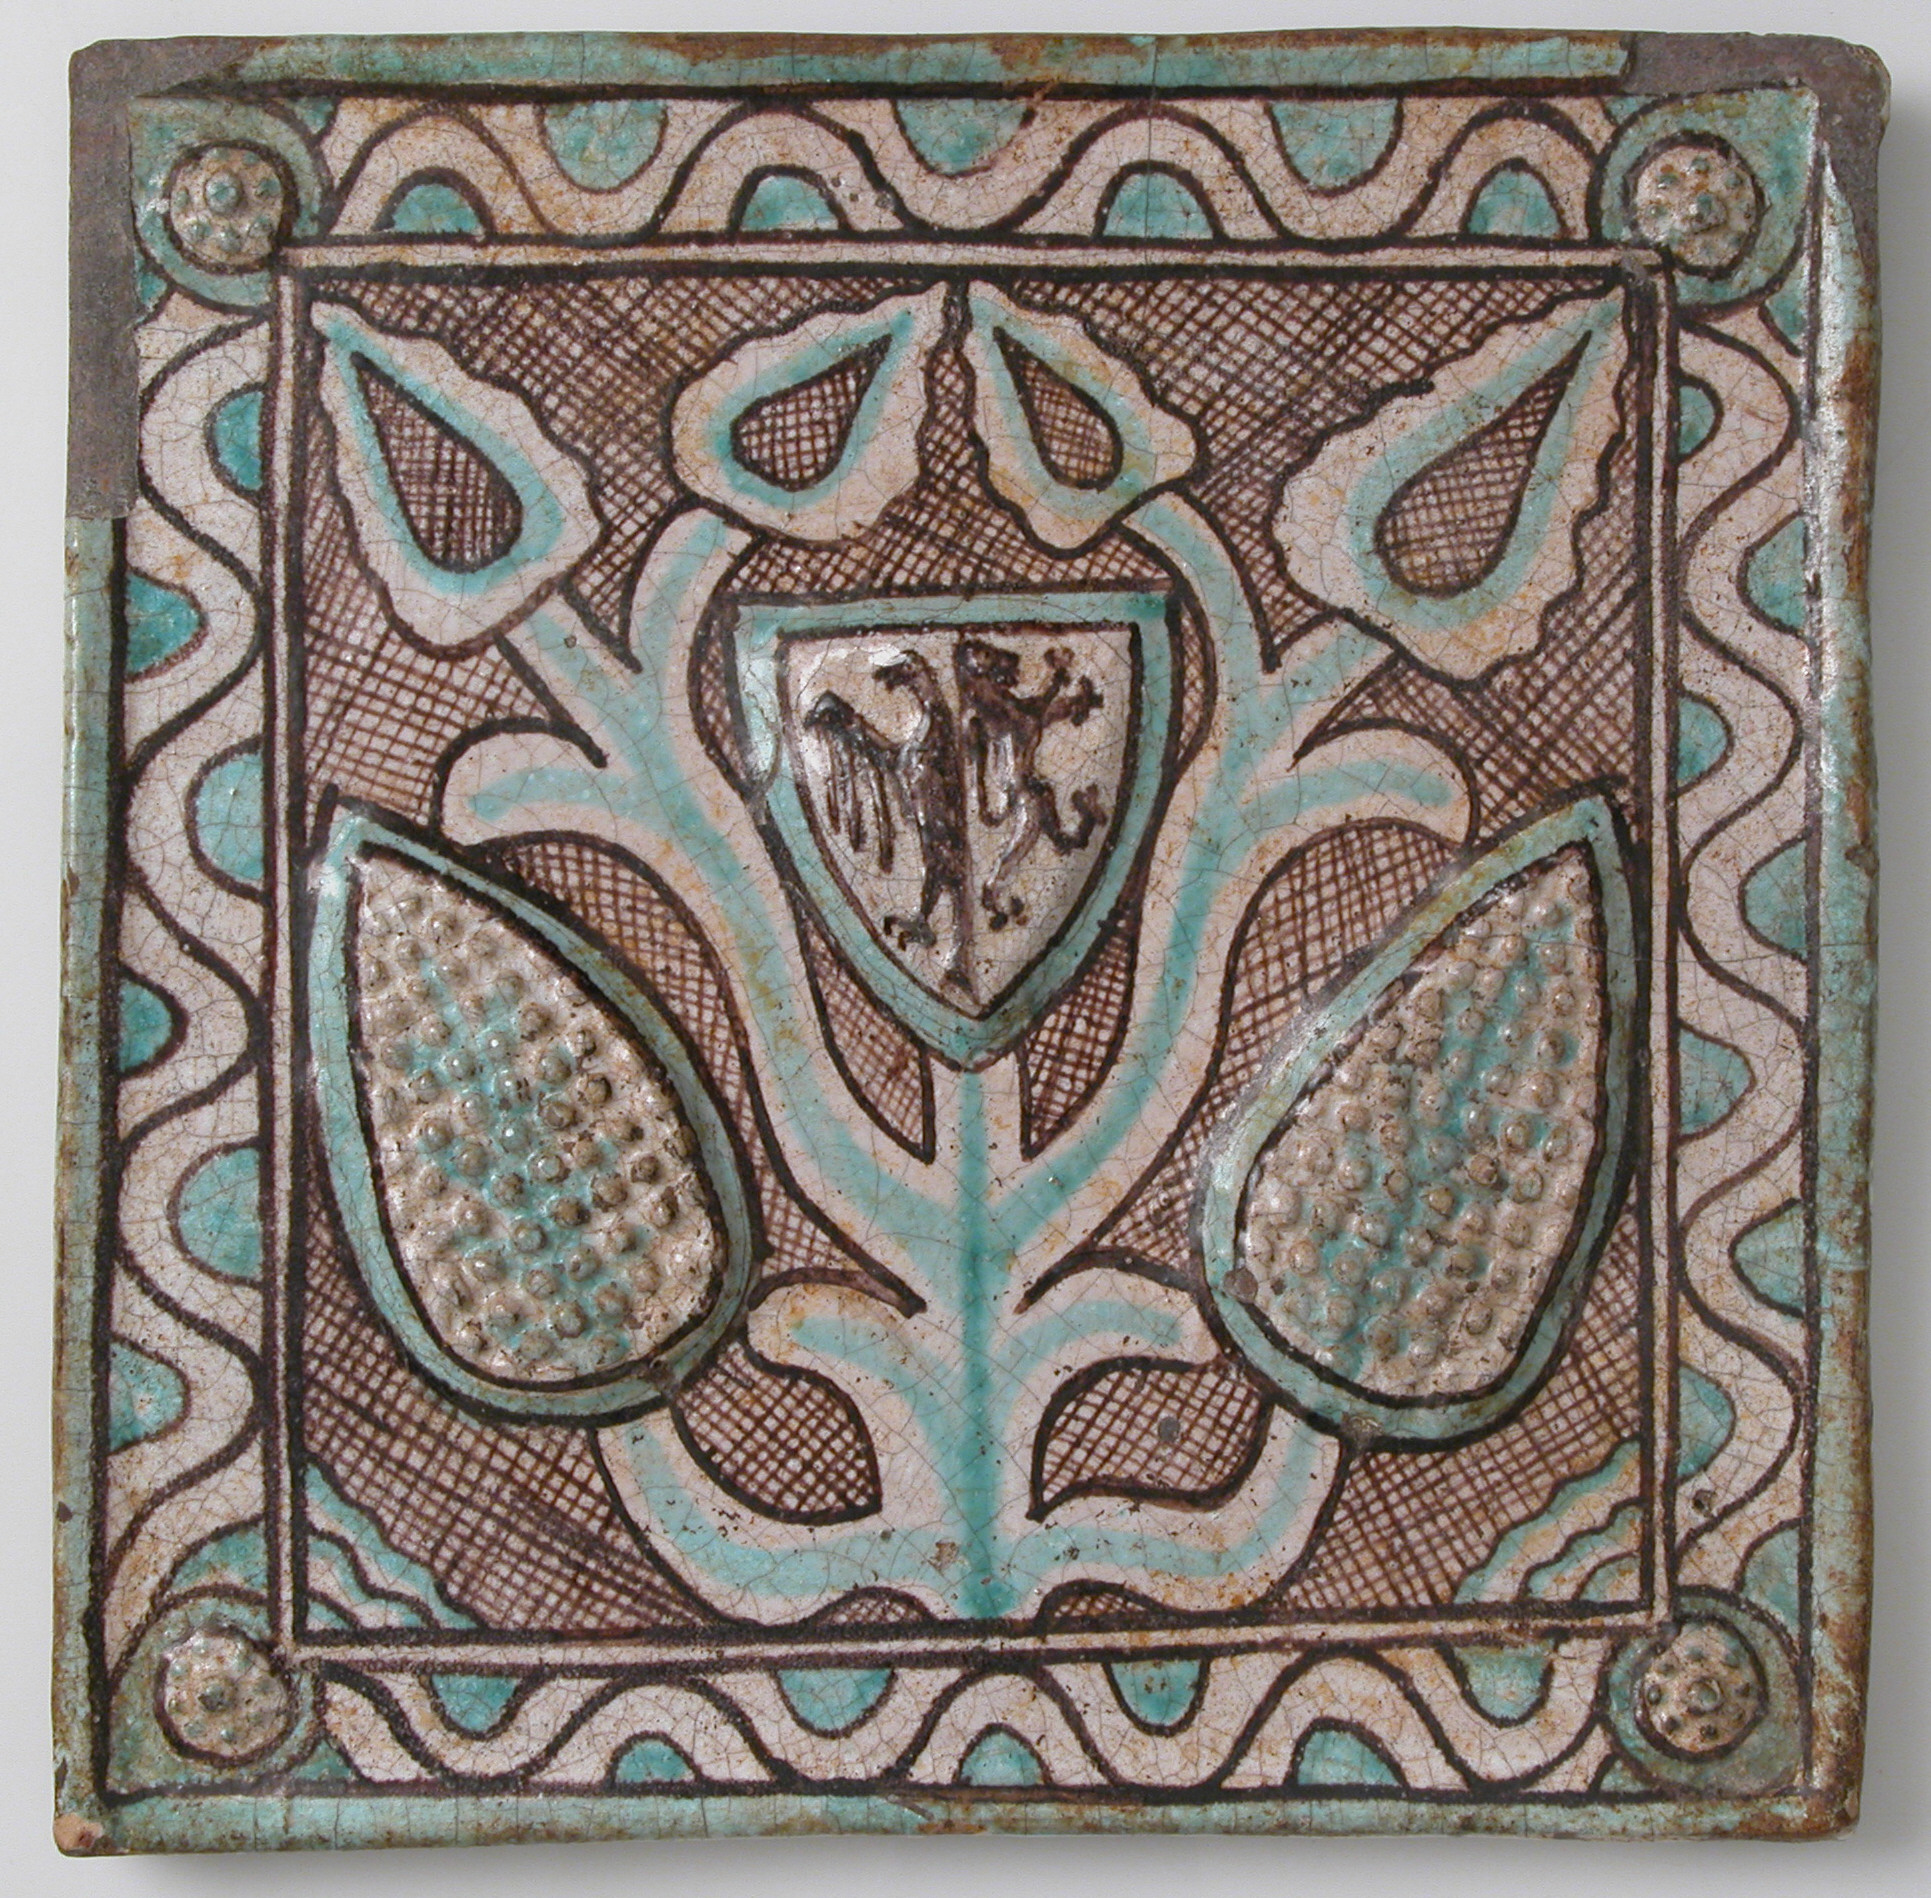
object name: tile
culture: italian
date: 1301-1500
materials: earthenware, glaze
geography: italy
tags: eagles,lions